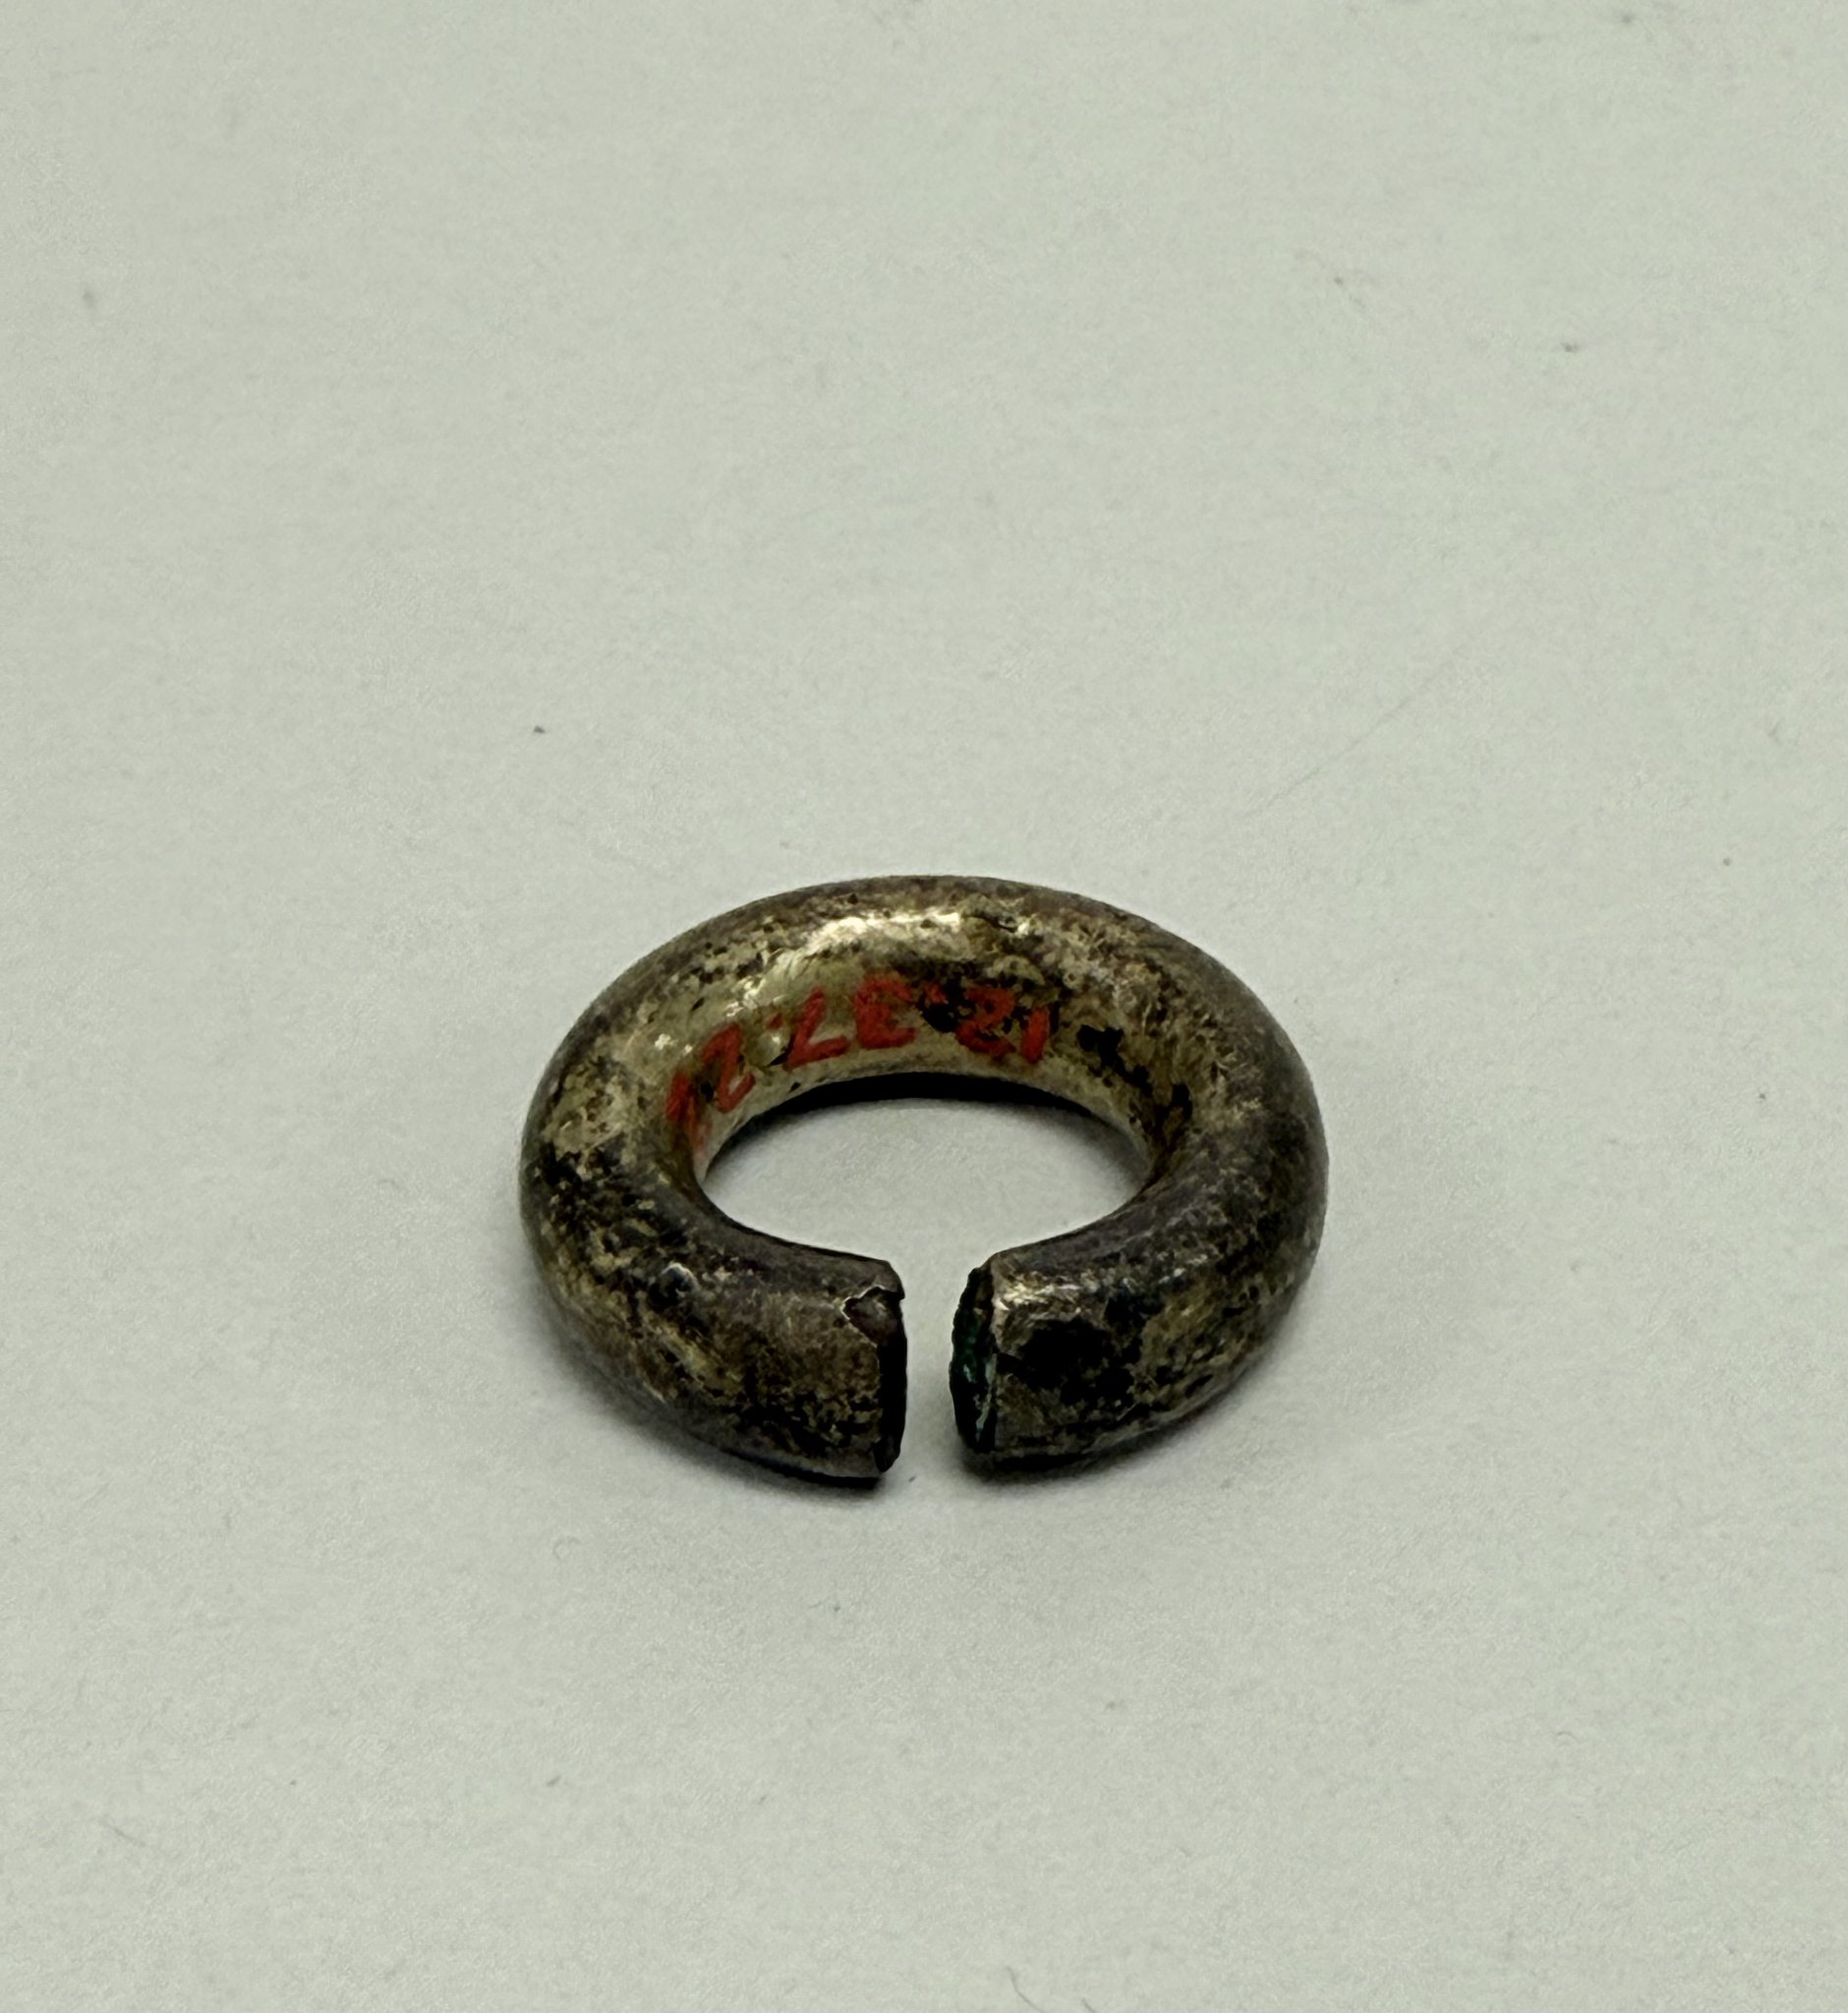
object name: earring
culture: japanese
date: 601-700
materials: metal